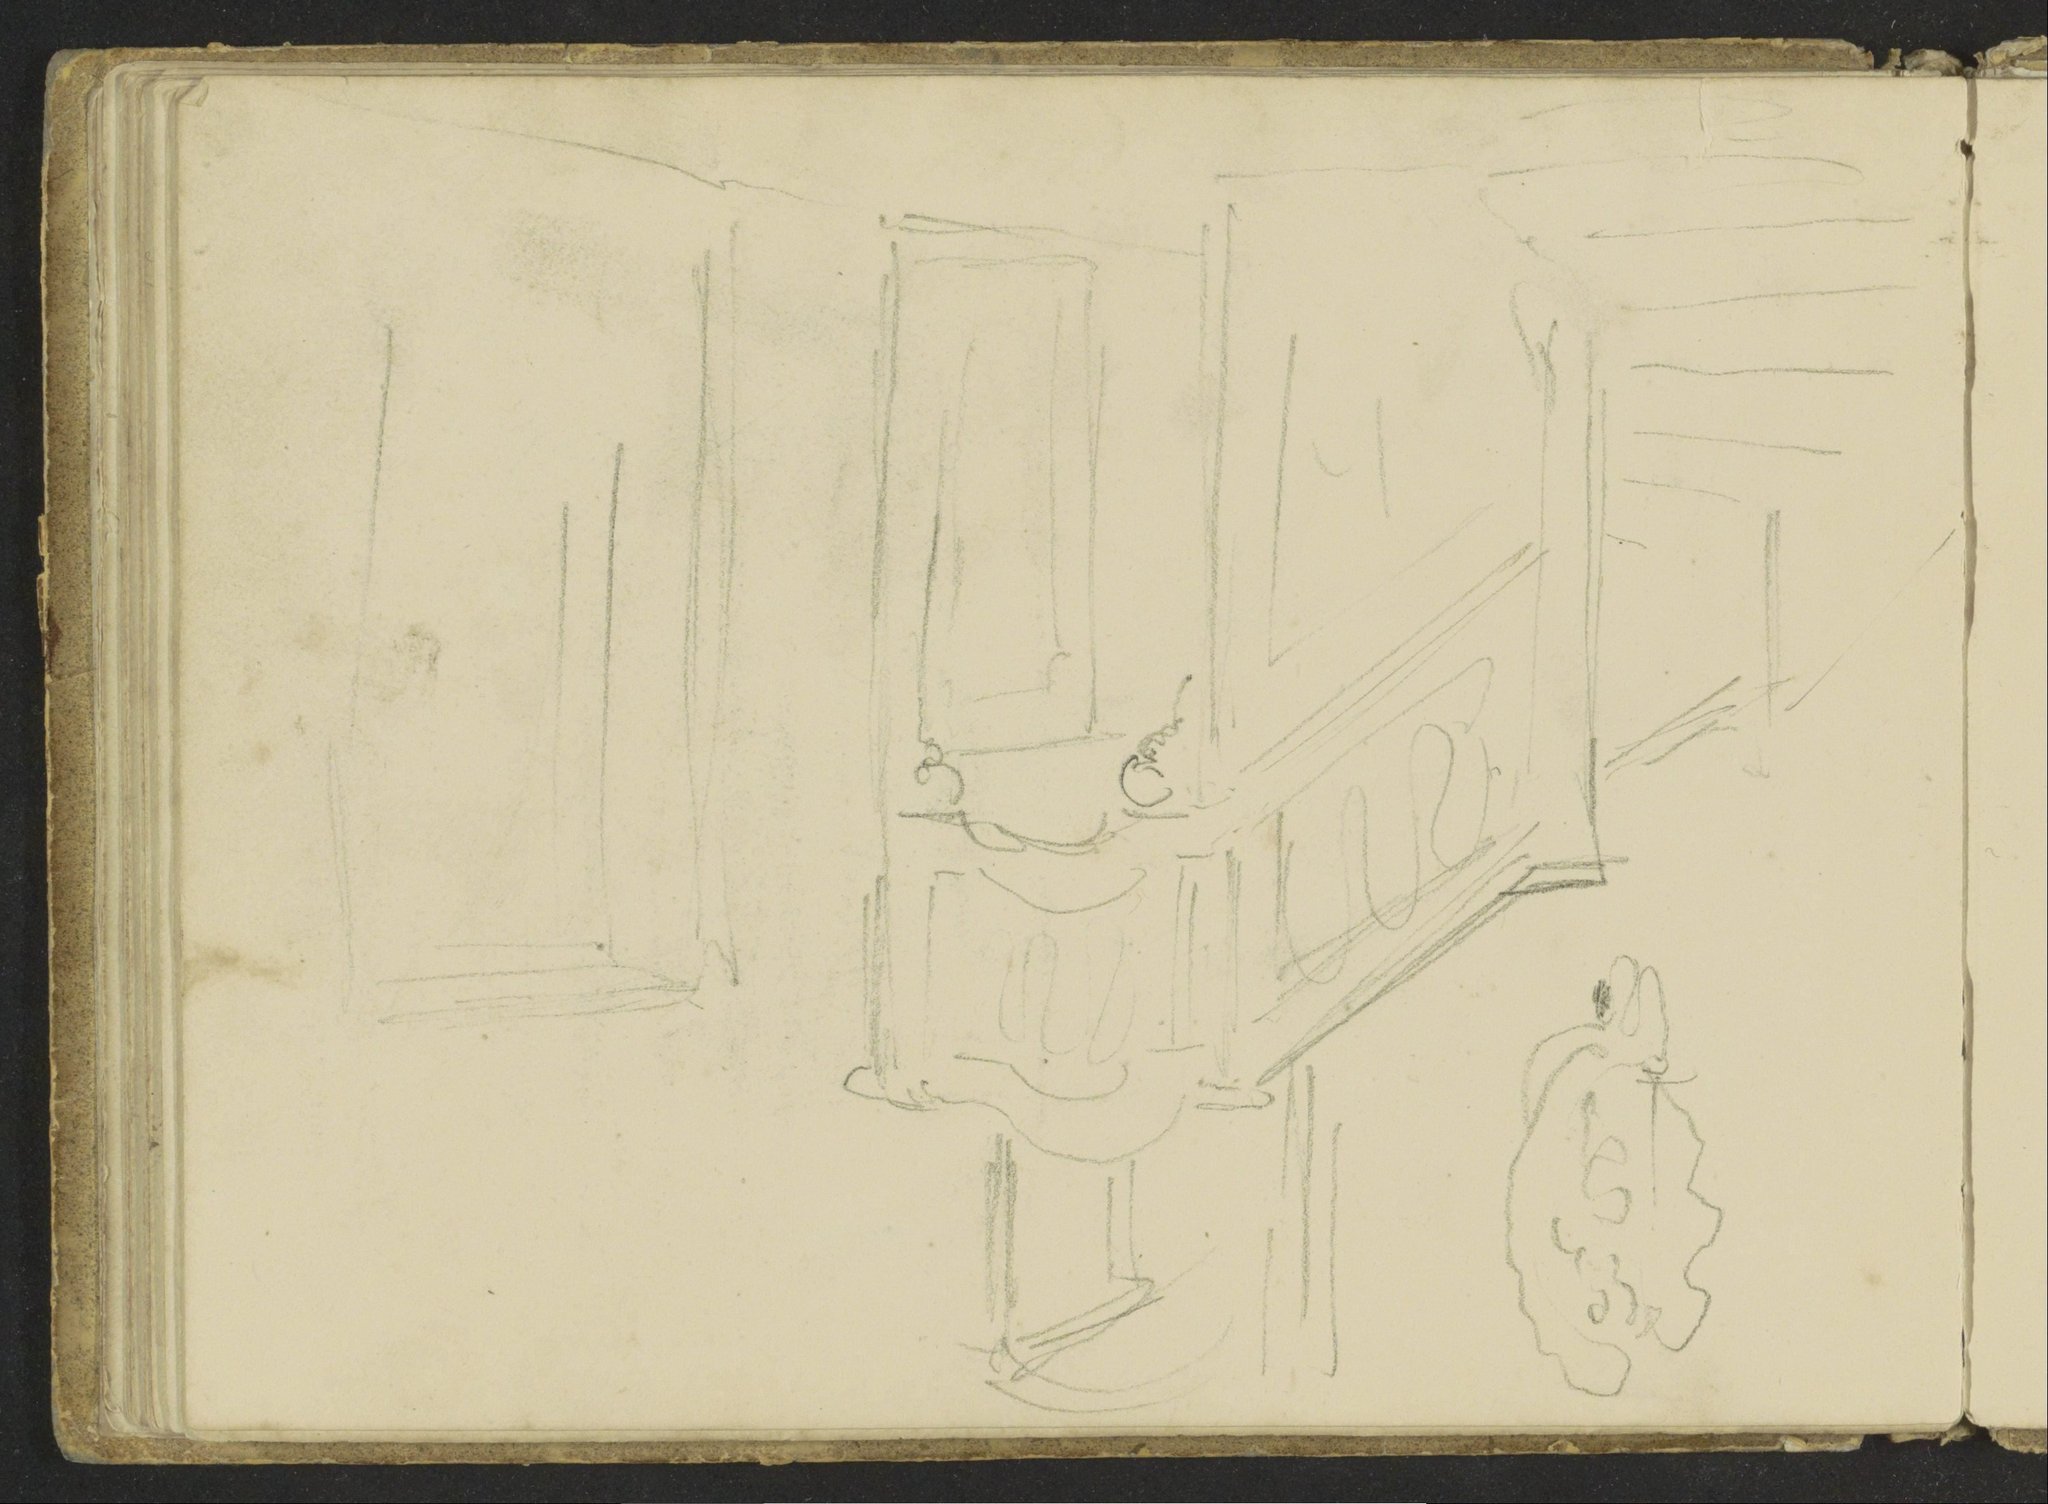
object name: sketchbook leaf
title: Hal met een gebogen trap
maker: willem hendrik schmidt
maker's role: draughtsman, painter, print maker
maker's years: 1809-1849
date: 1819-1849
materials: paper, pencil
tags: vestibule, hall, staircase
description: Blad 26 verso uit een schetsboek met 36 bladen.